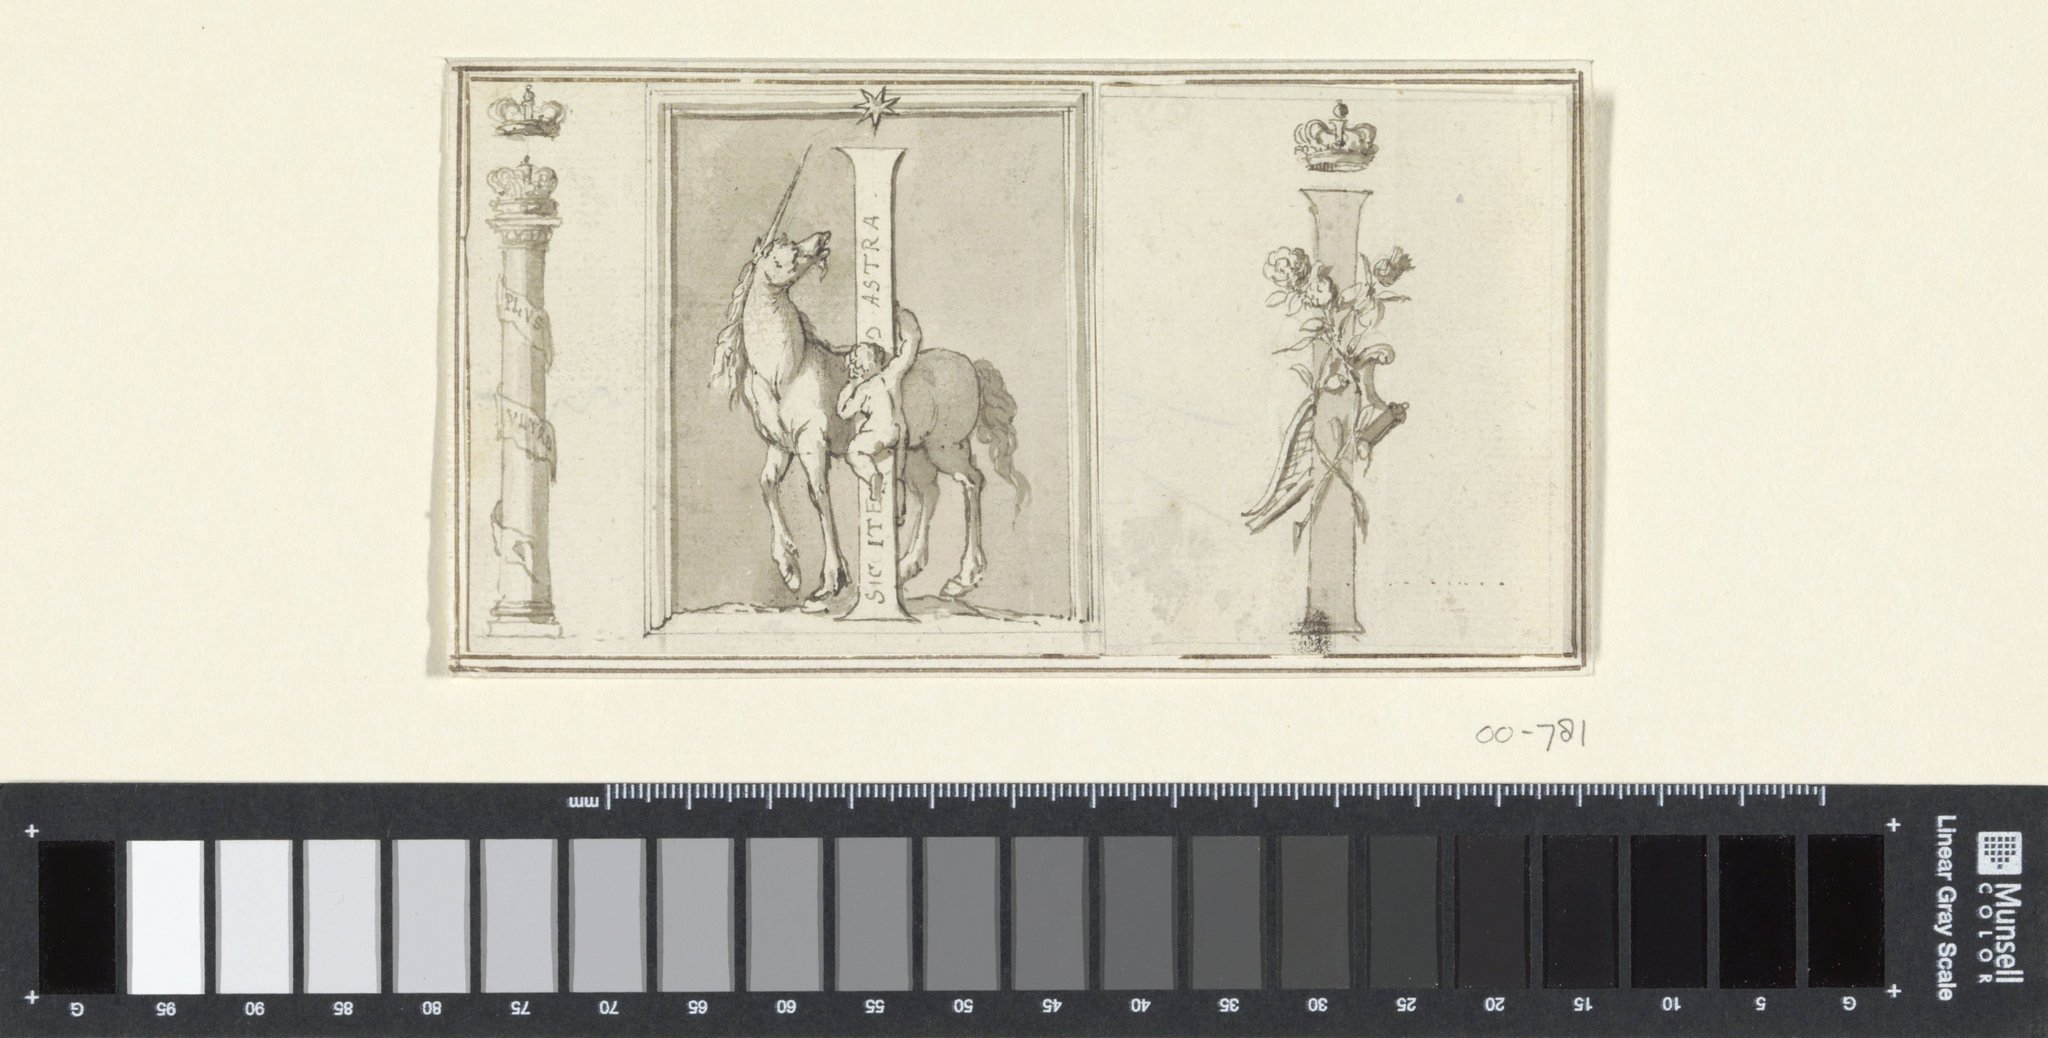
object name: ornamenttekening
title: Letter I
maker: Anonymous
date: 1600-1800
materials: ink, paper, pencil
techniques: brush, pen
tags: fancy letters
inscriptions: stamp: Lugt 2165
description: Drie ontwerpen voor de letter I. Links een gekroonde zuil met banderol, in het midden een eenhoorn met een zuil met ster beklommen door een putto, rechts een bekroonde zuil met bloemen en een harp.